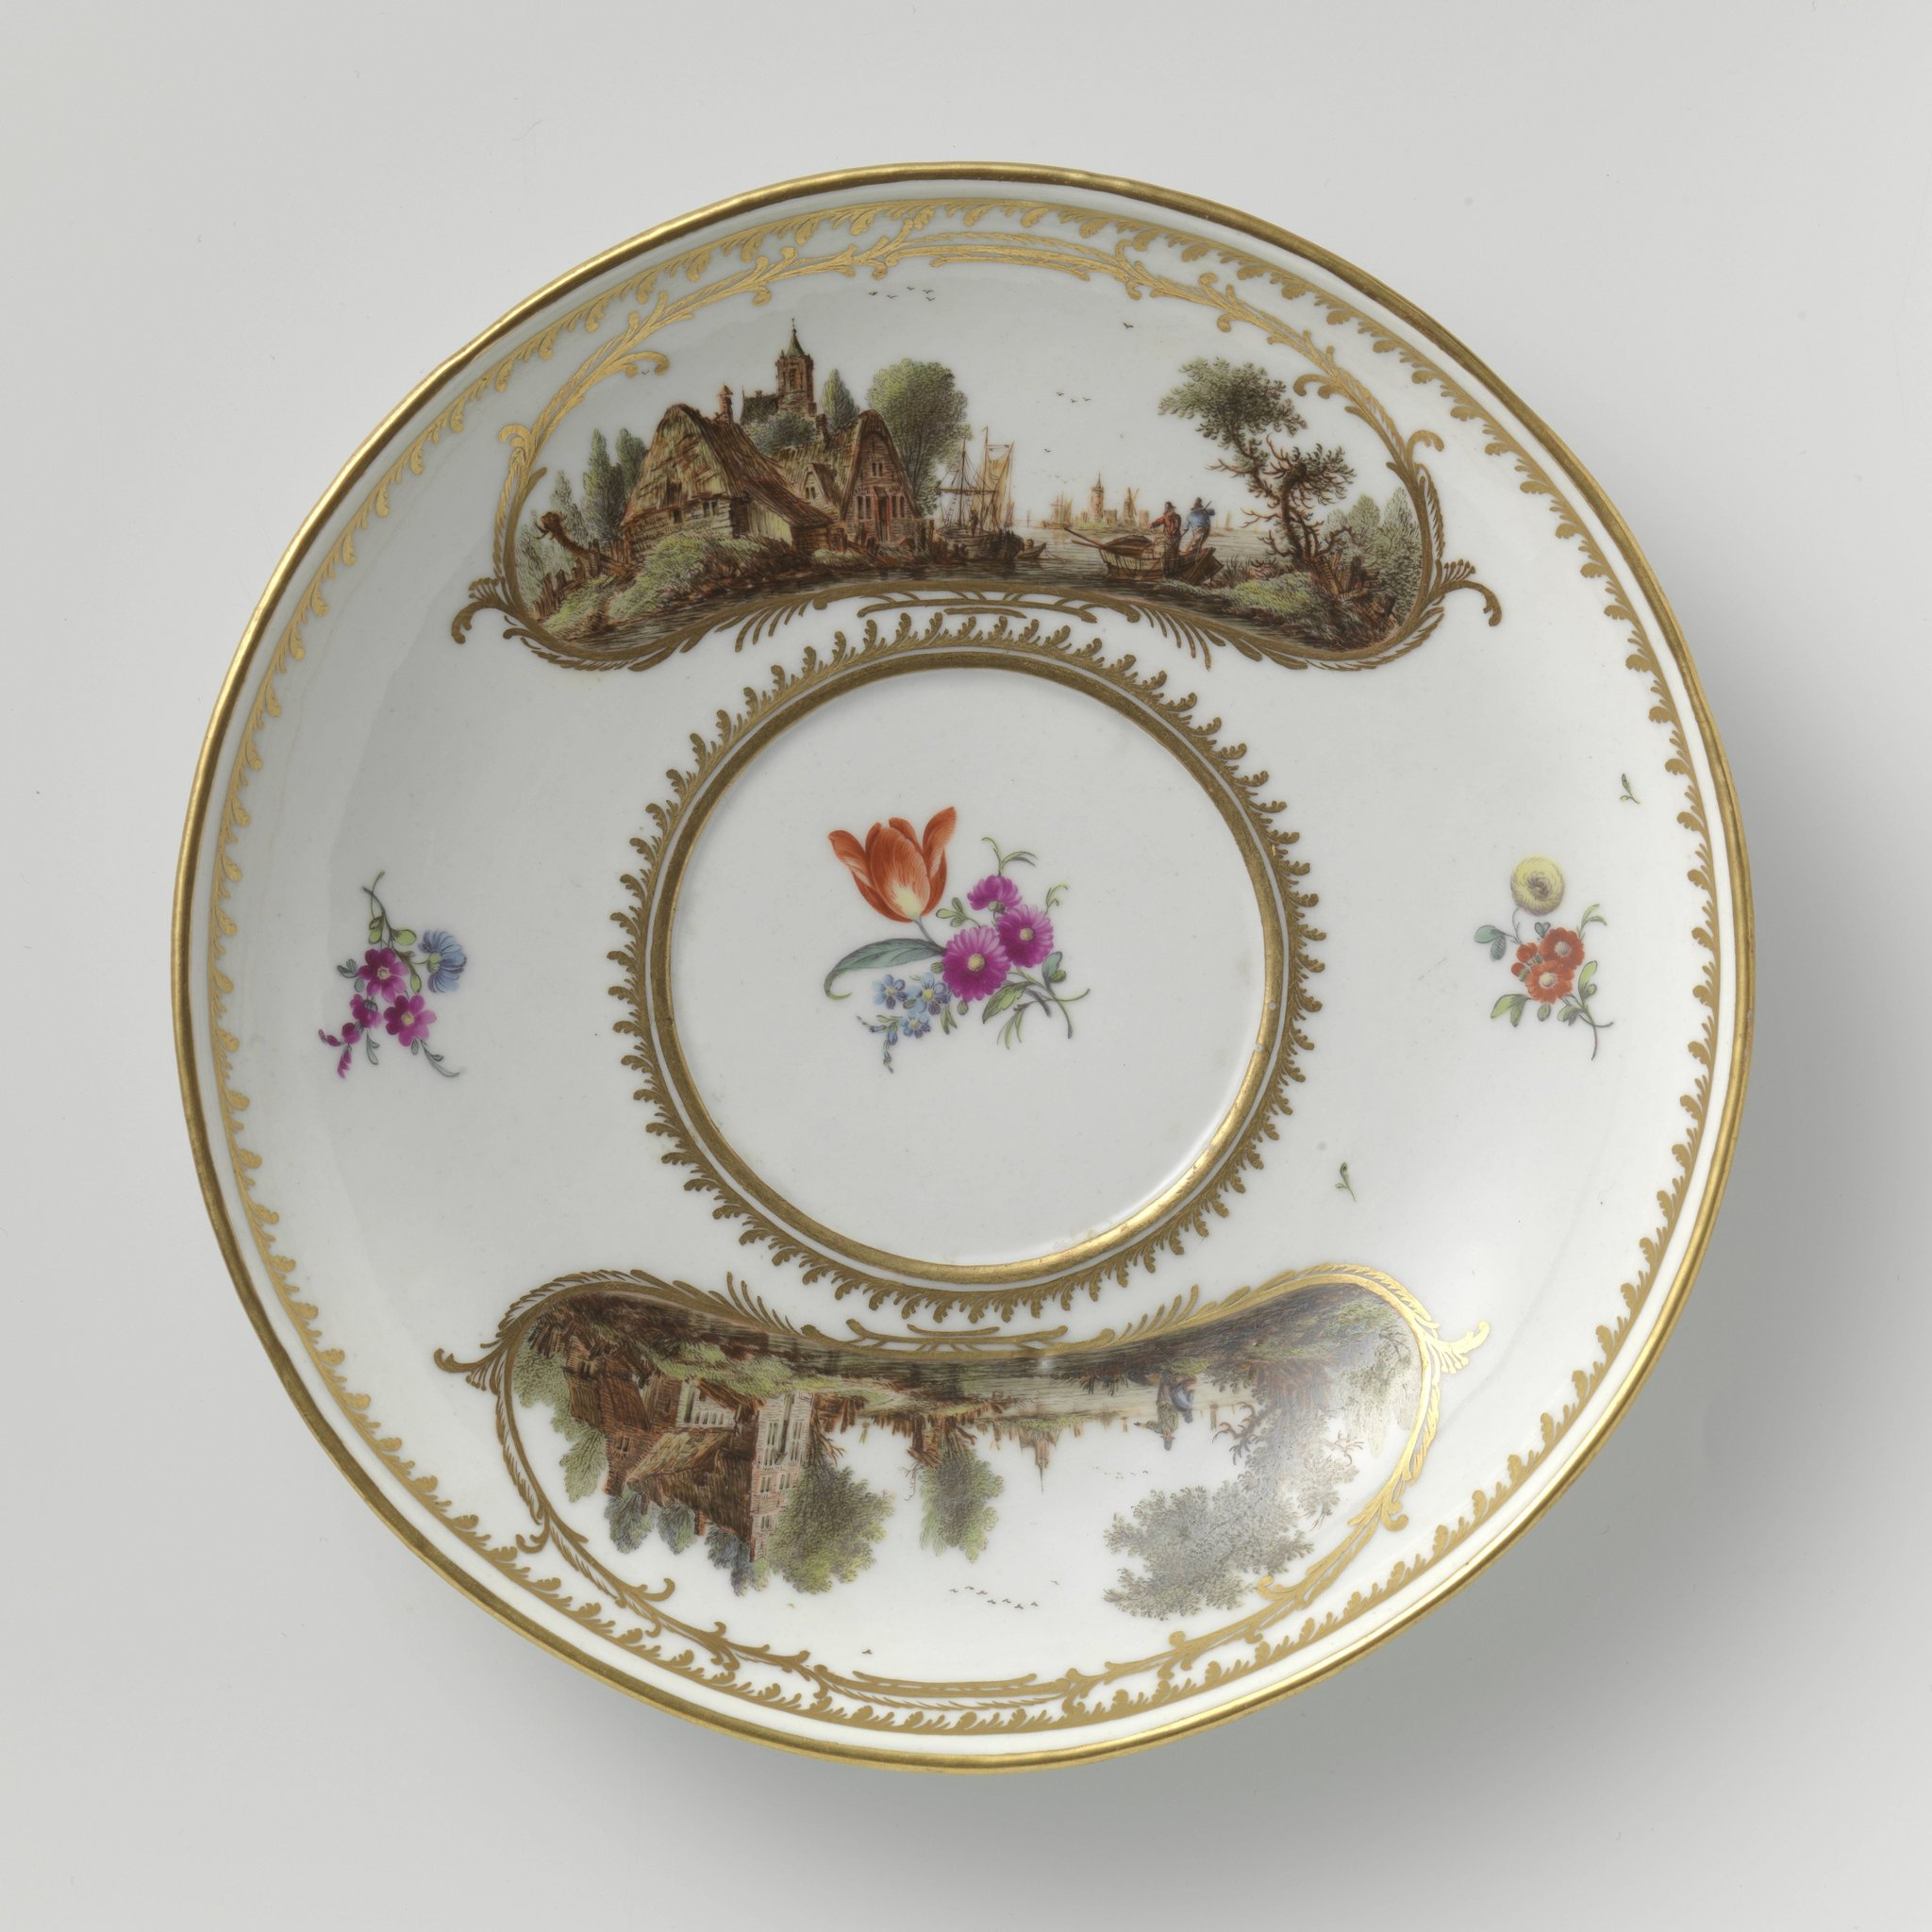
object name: platter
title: Tureen and stand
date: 1778-1782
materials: porcelain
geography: loosdrecht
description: Manufactuur Oud-Loosdrecht Loosdrecht, c. 1778–1782 hard-paste porcelain